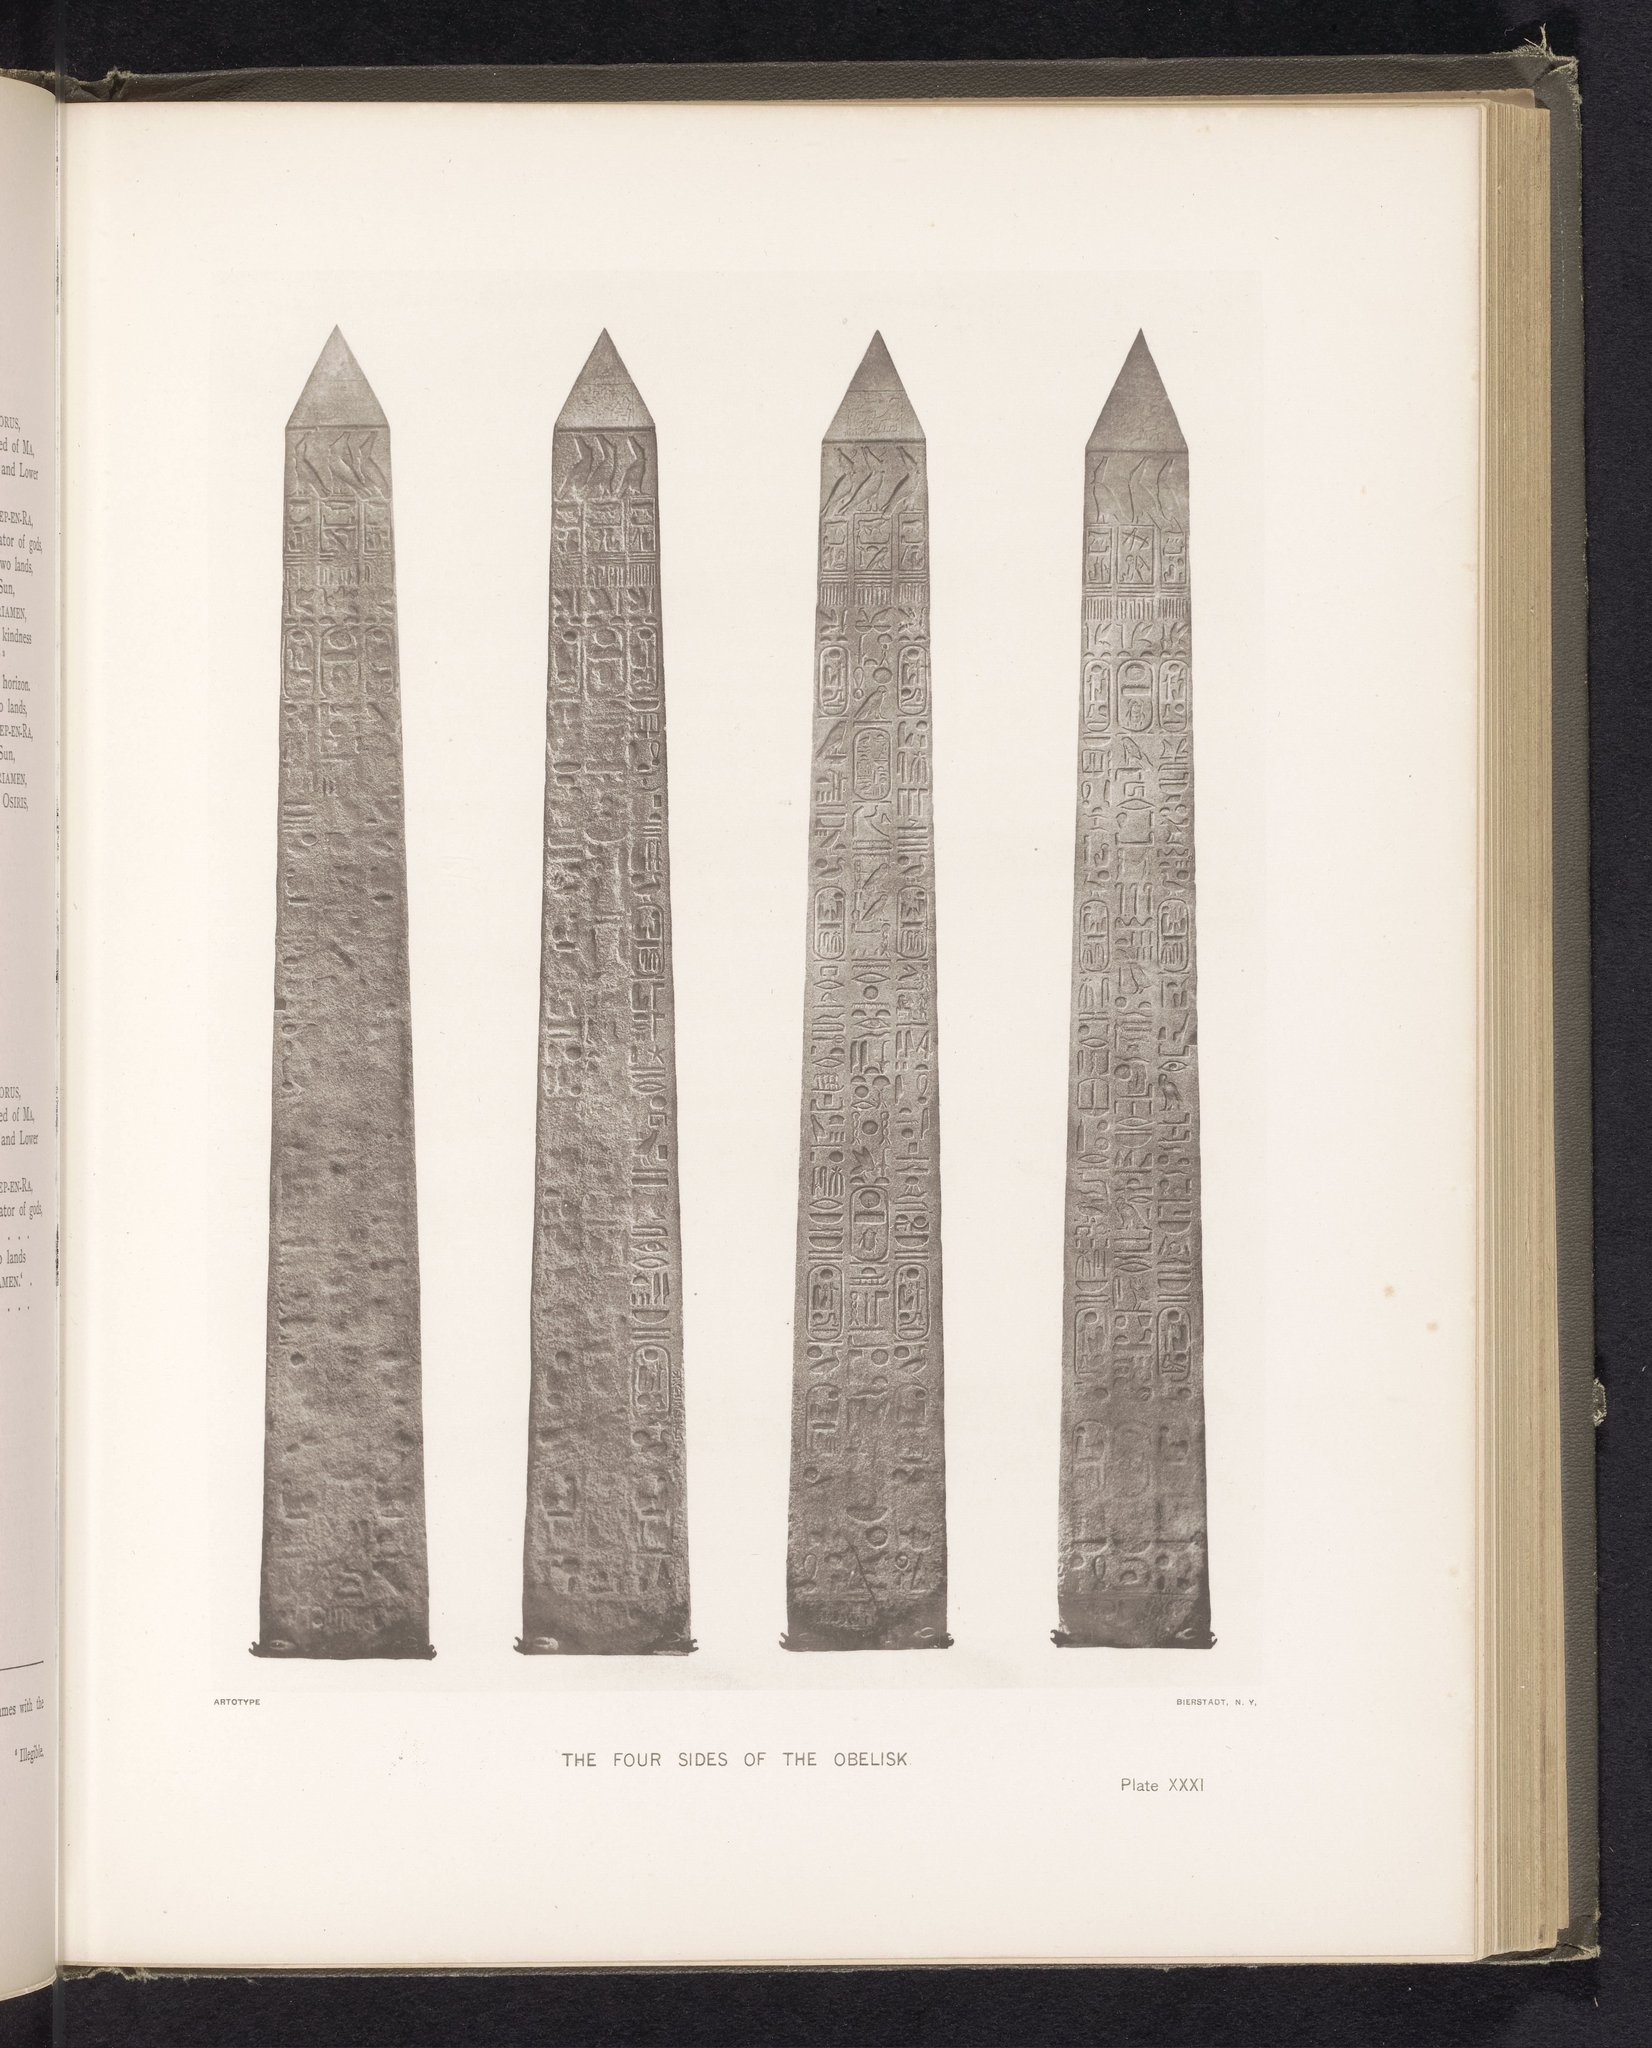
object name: page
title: The four sides of the obelisk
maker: Anonymous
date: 1881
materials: paper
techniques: photograph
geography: central park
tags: obelisk, needle, sculpture (+ relief ~ sculpture)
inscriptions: inscription: ‘Plate XXXI’